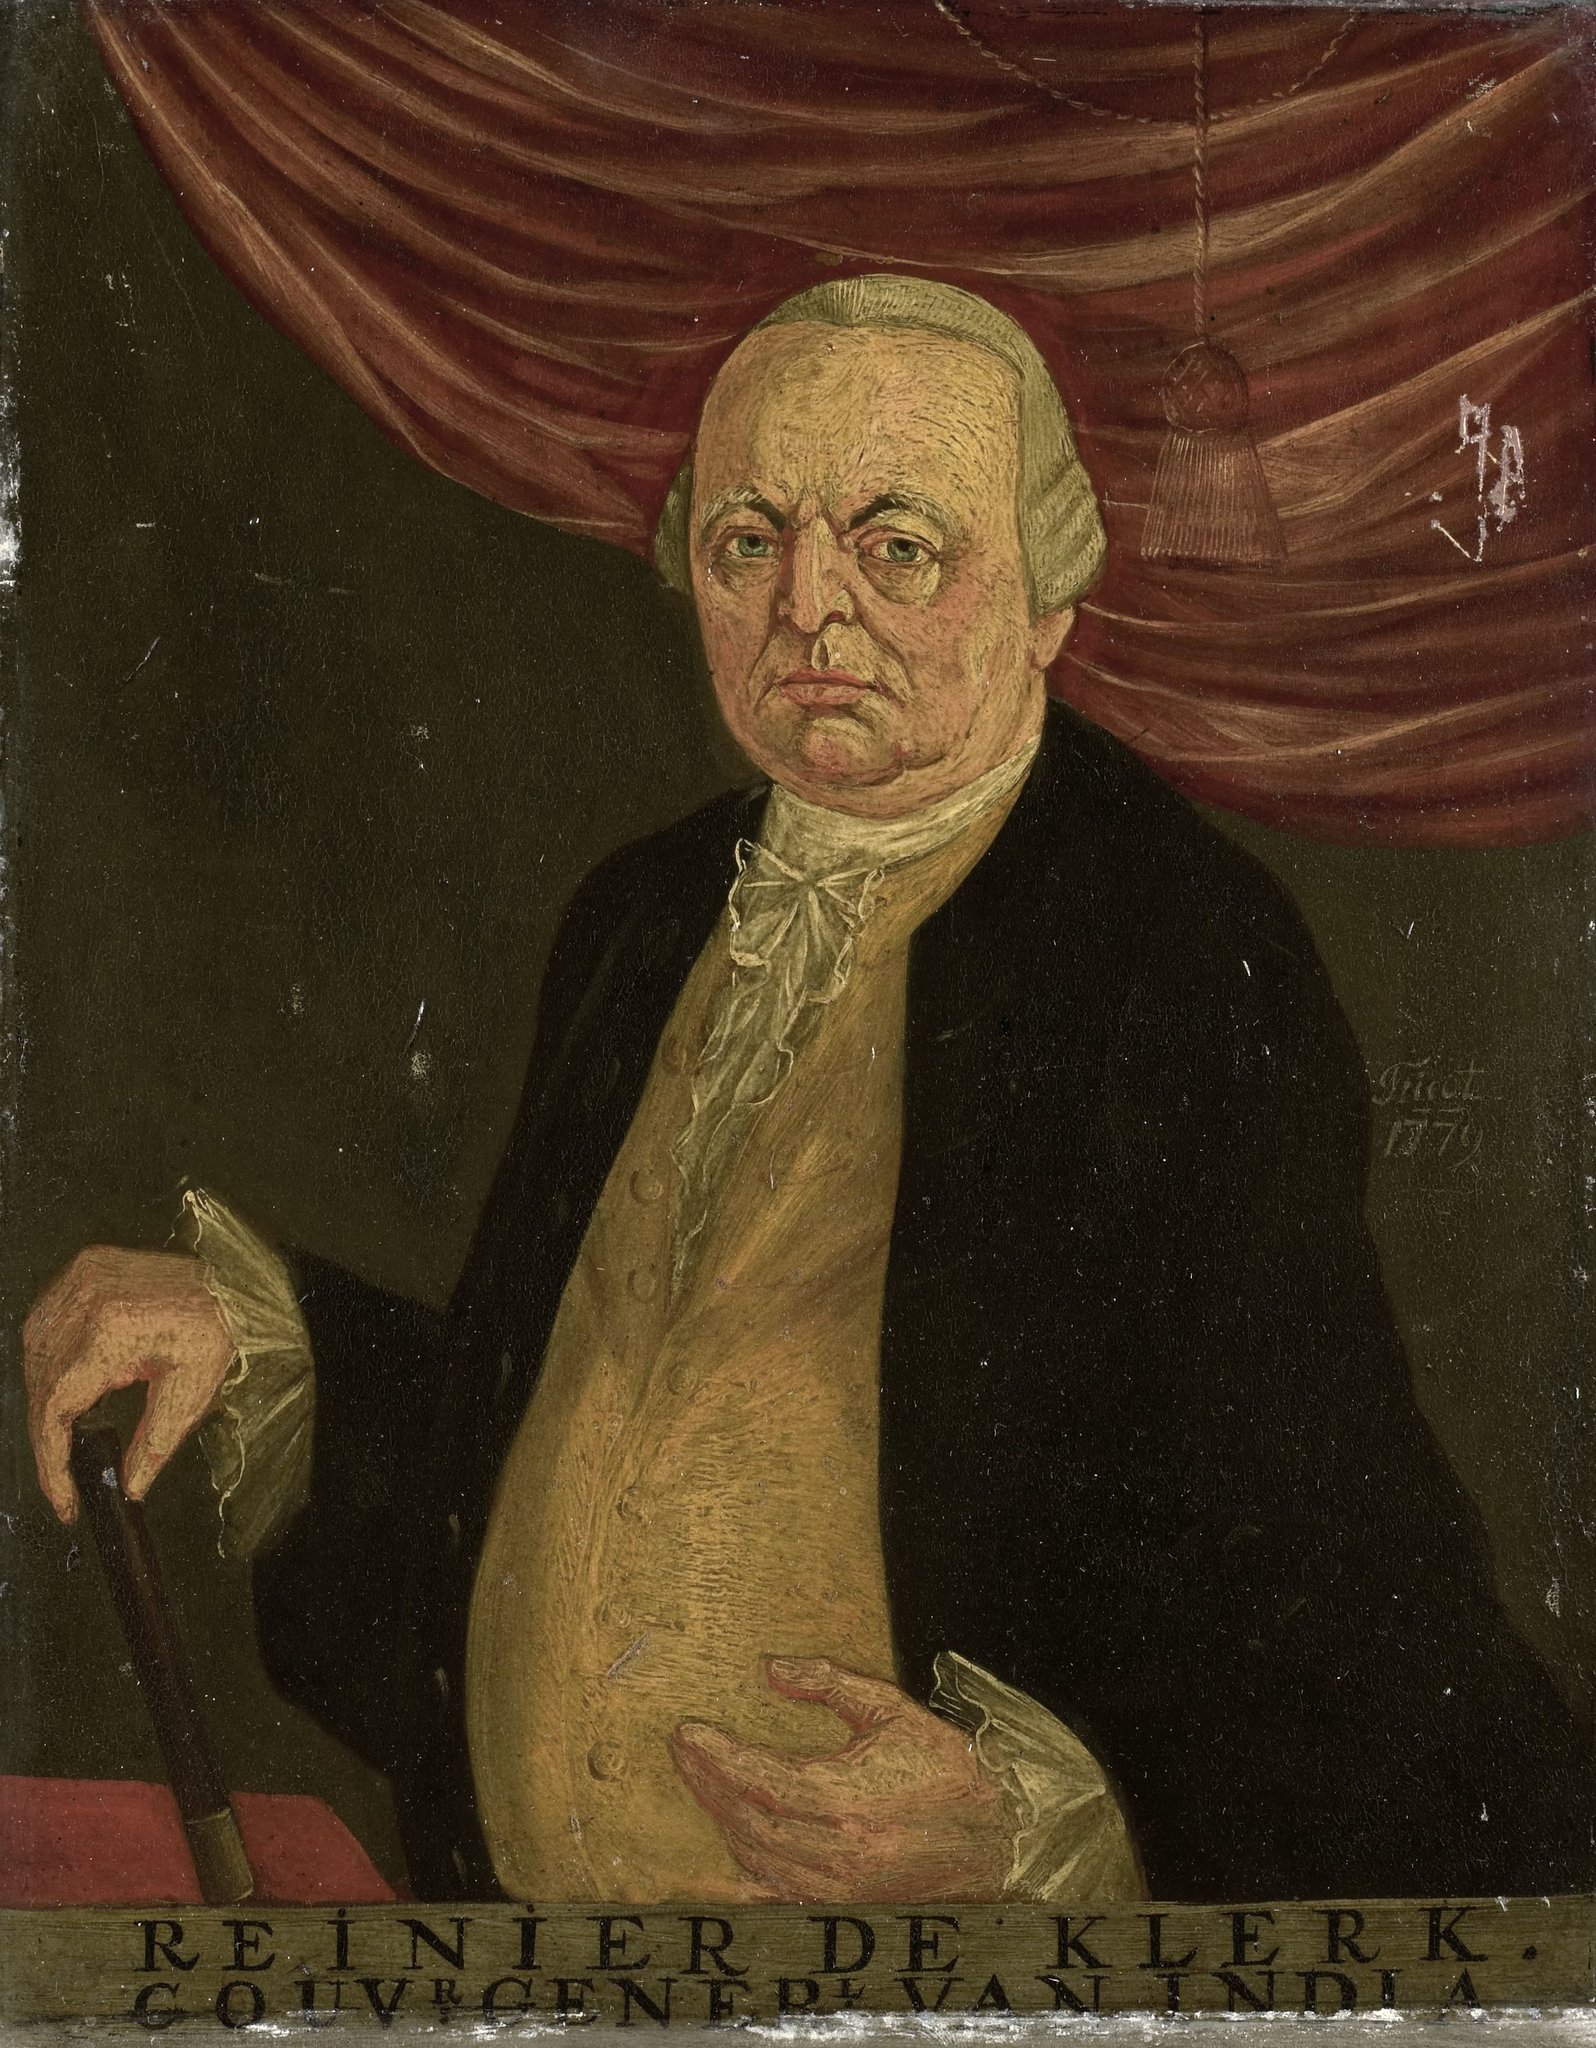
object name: painting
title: Portrait of Reinier de Klerk, Governor-General of the Dutch East India Company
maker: franciscus josephus fricot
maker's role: painter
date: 1779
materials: copper, oil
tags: middelburg, dutch east indies, the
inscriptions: signature and date: ‘Fricot. 1779’, inscription: ‘Reinier de Klerk. Gouv.r Gener.l van India.’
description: Portret van Reinier de Klerk (1710-80). Gouverneur-generaal (1777-80). Staande, ten halven lijve, naar links, met de commandostaf in de rechterhand. Onderdeel van een reeks van kopieën naar portretten van de gouverneurs-generaal van het voormalige Nederlands Oost-Indië, waarschijnlijk afkomstig van de Verenigde Oostindische Compagnie.